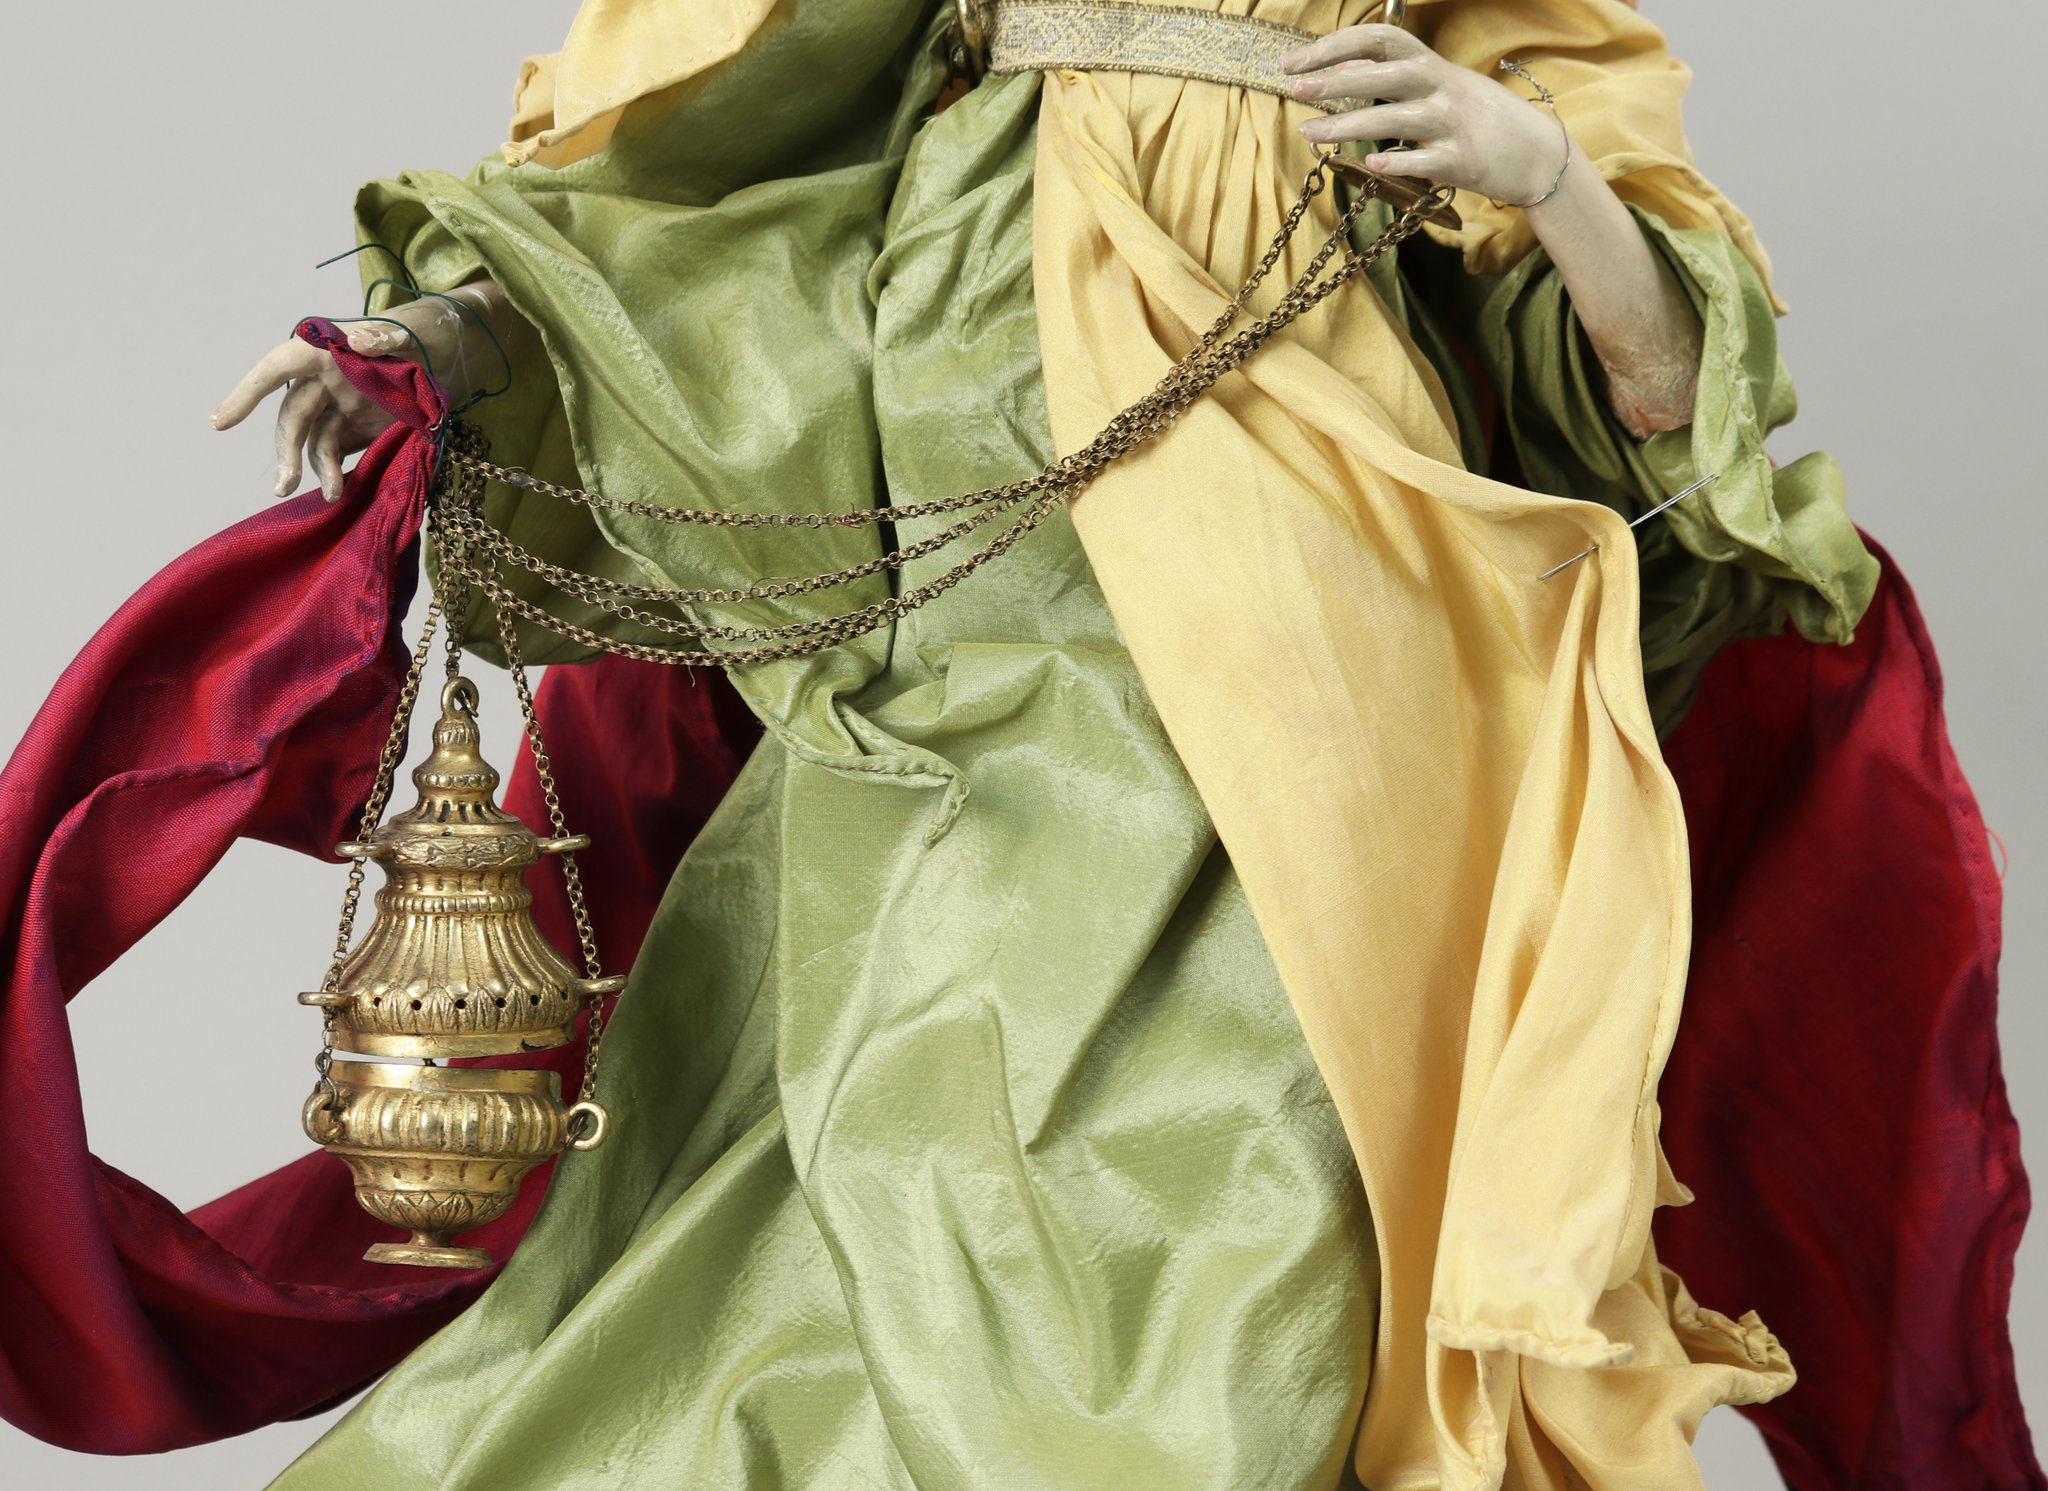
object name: crèche figure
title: Censer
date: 1751-1800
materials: silver gilt